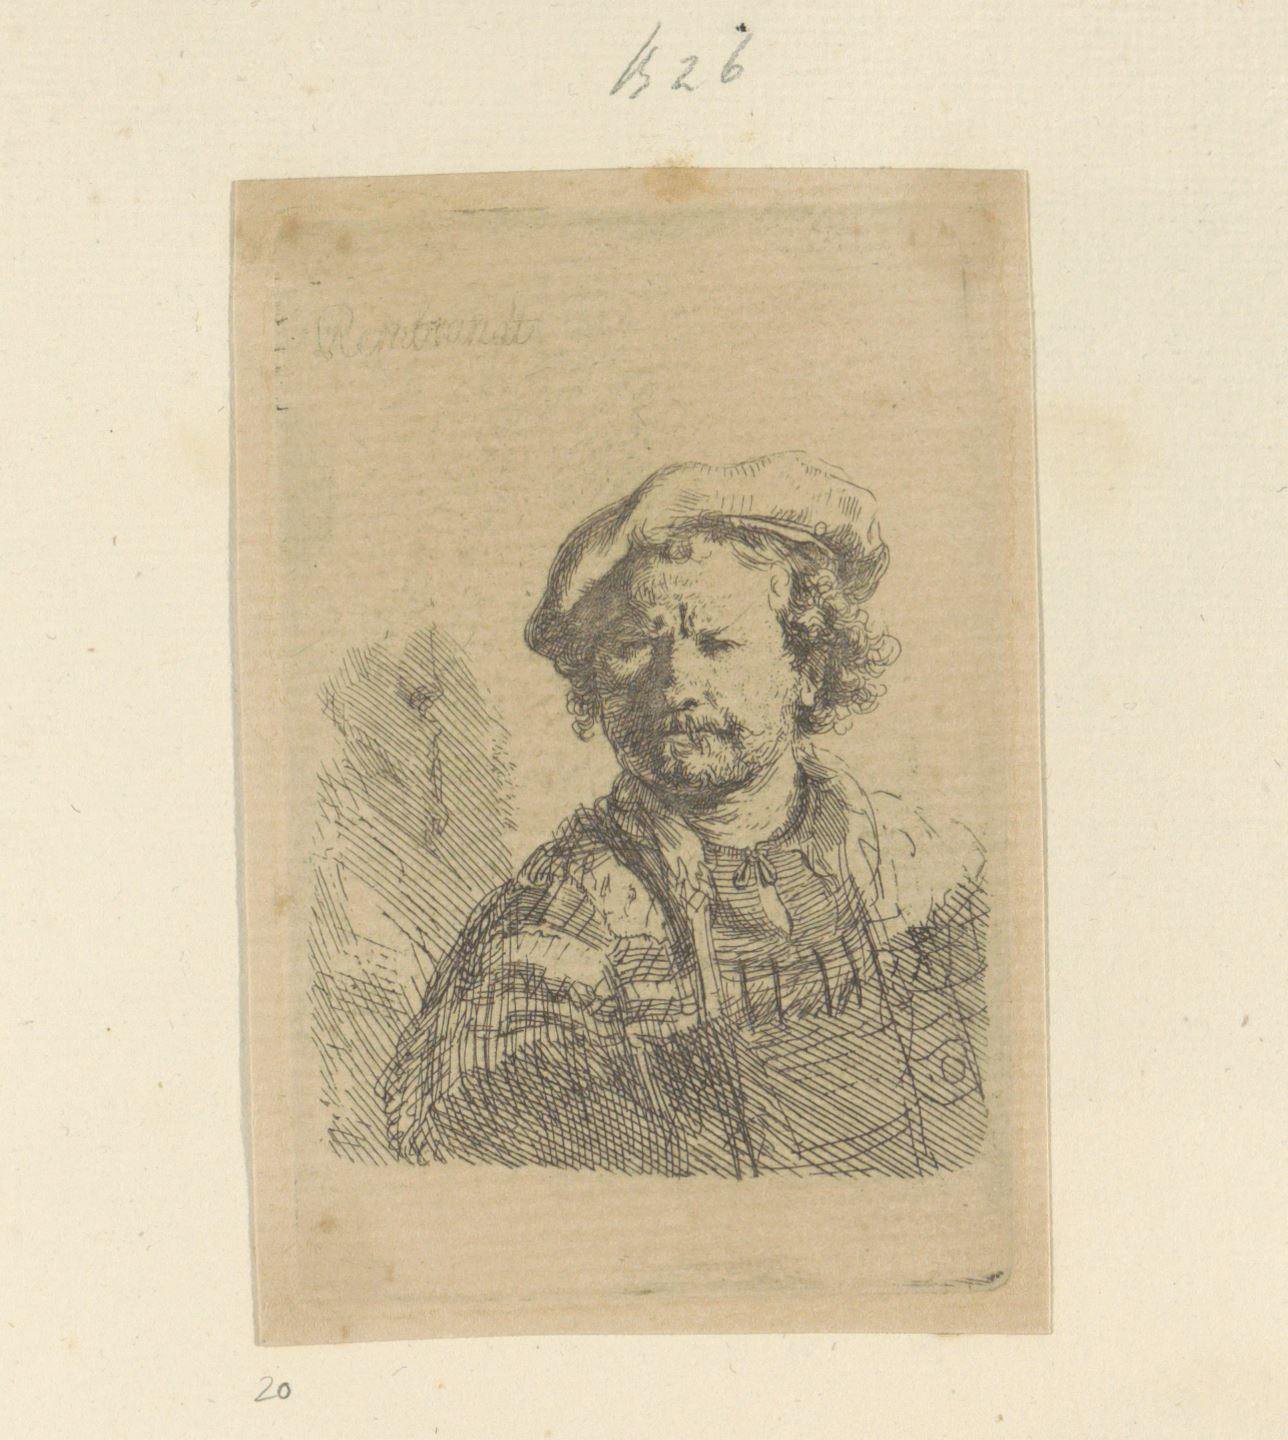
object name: print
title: Zelfportret met baret en bewerkte mantel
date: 1640-1644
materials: paper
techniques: etching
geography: paris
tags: leiden, amsterdam, print maker, draughtsman, rembrandt van rijn